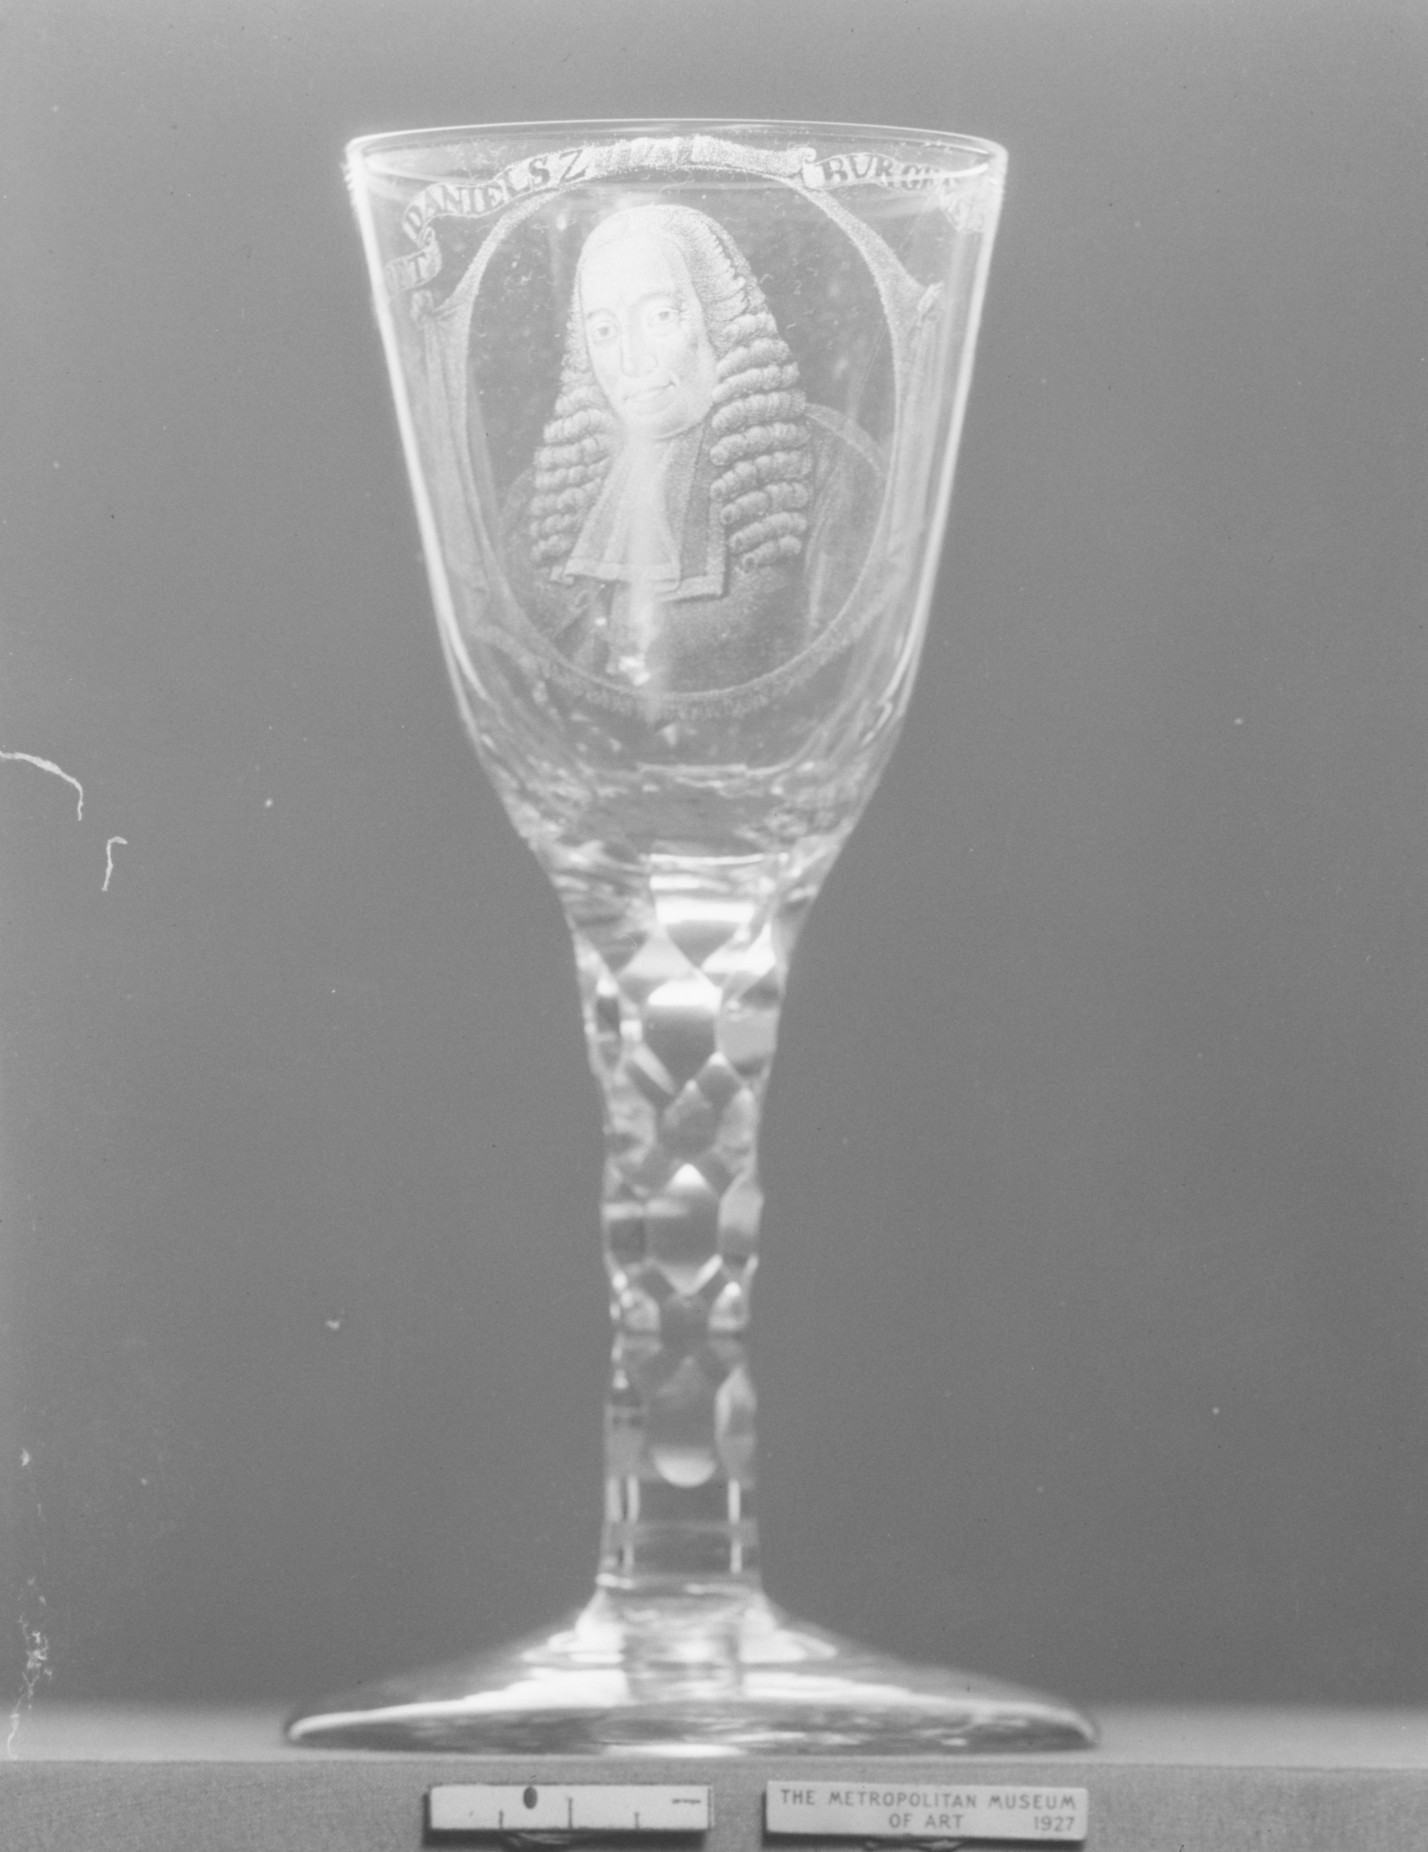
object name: wineglass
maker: david wolff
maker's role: engraver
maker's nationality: dutch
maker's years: 1732-1798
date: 1785-1790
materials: glass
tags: men,portraits